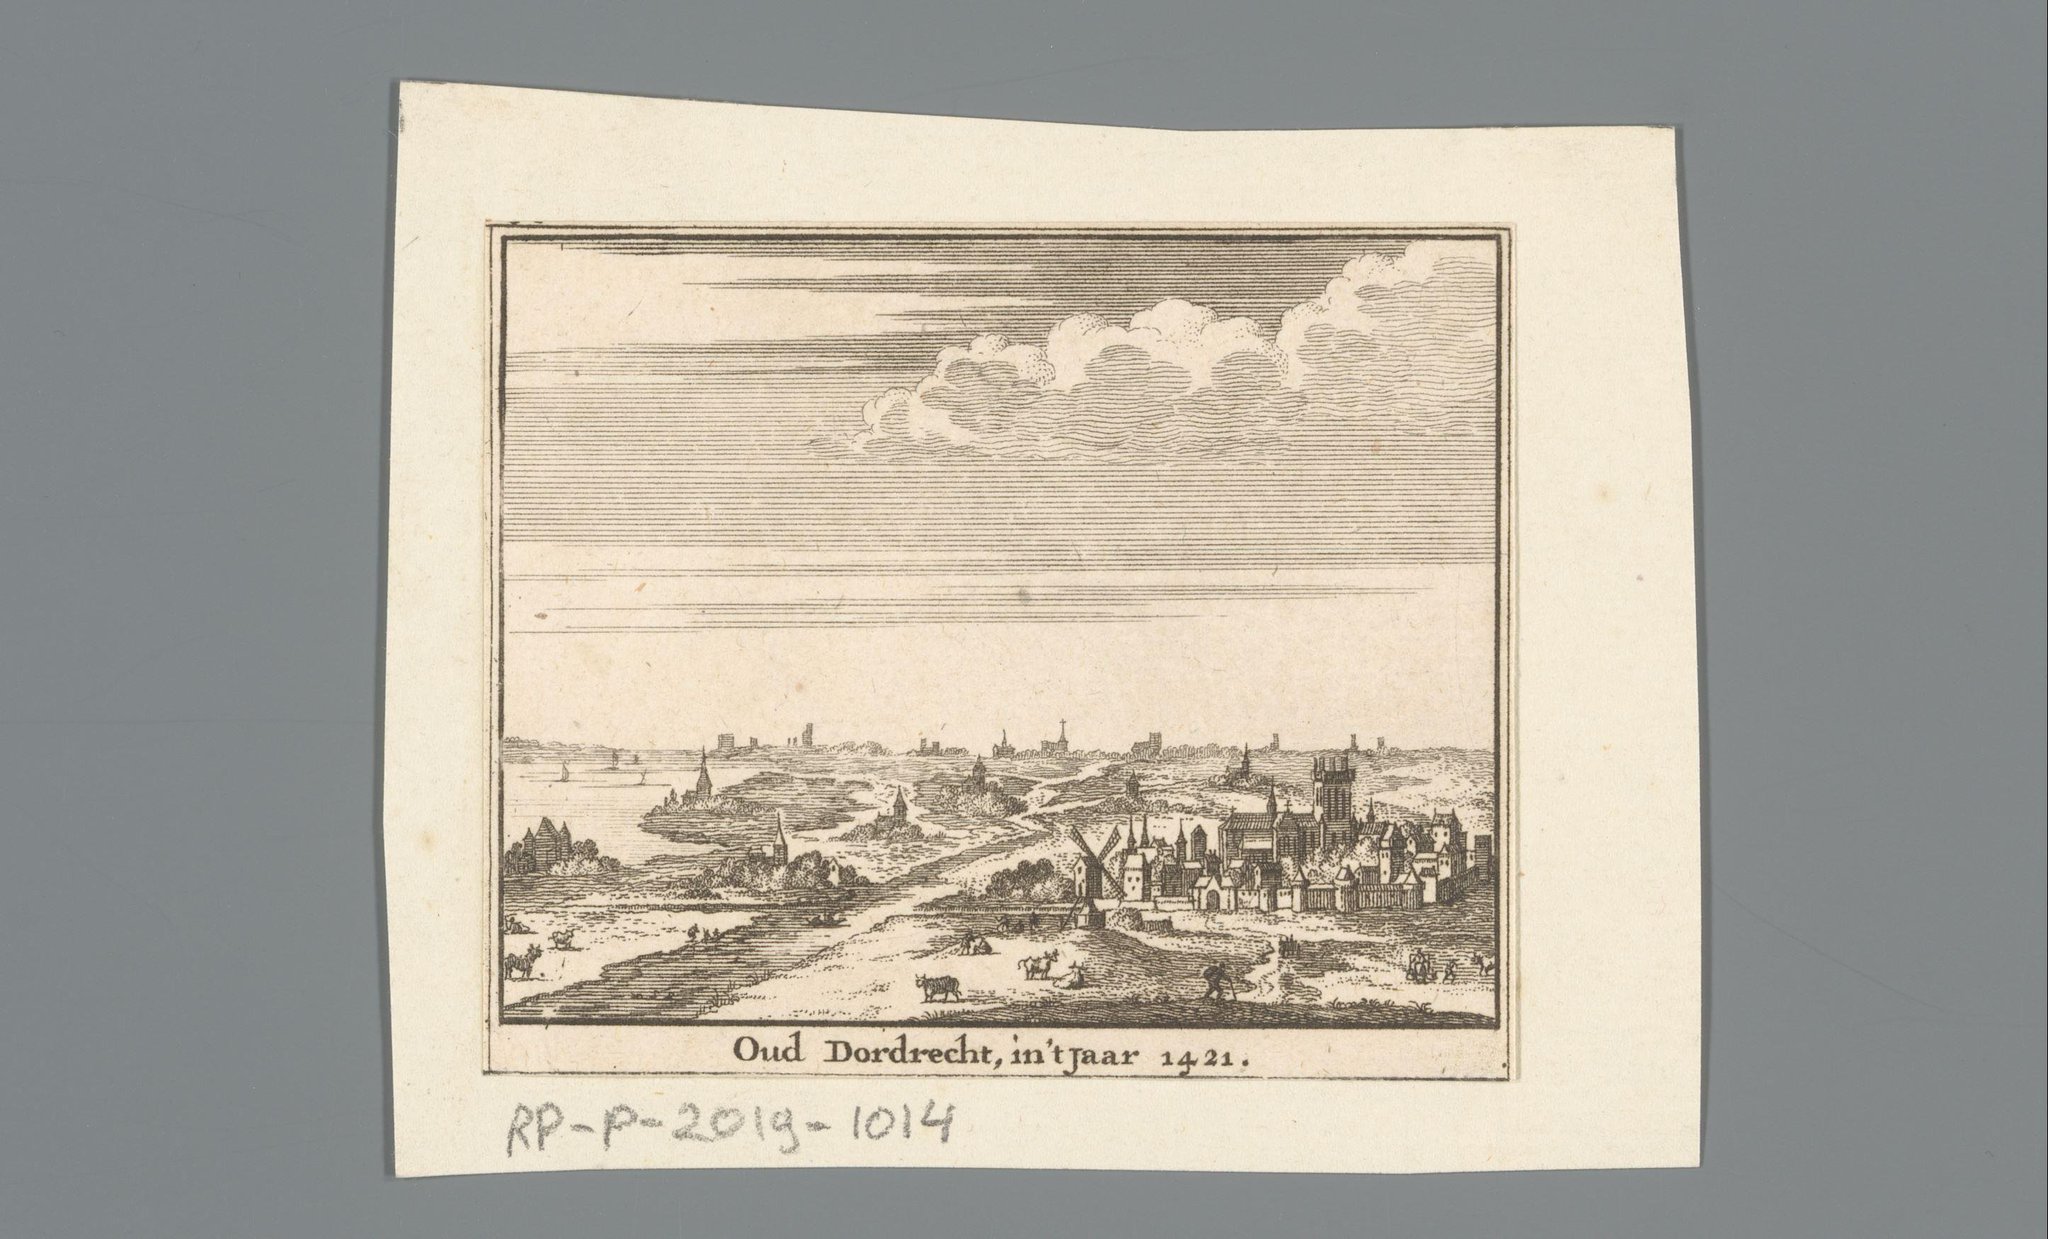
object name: print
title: Oud Dordrecht, in 't jaar 1421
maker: Anonymous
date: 1670-1720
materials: paper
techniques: etching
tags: city-view, and landscape with man-made constructions, dordrecht